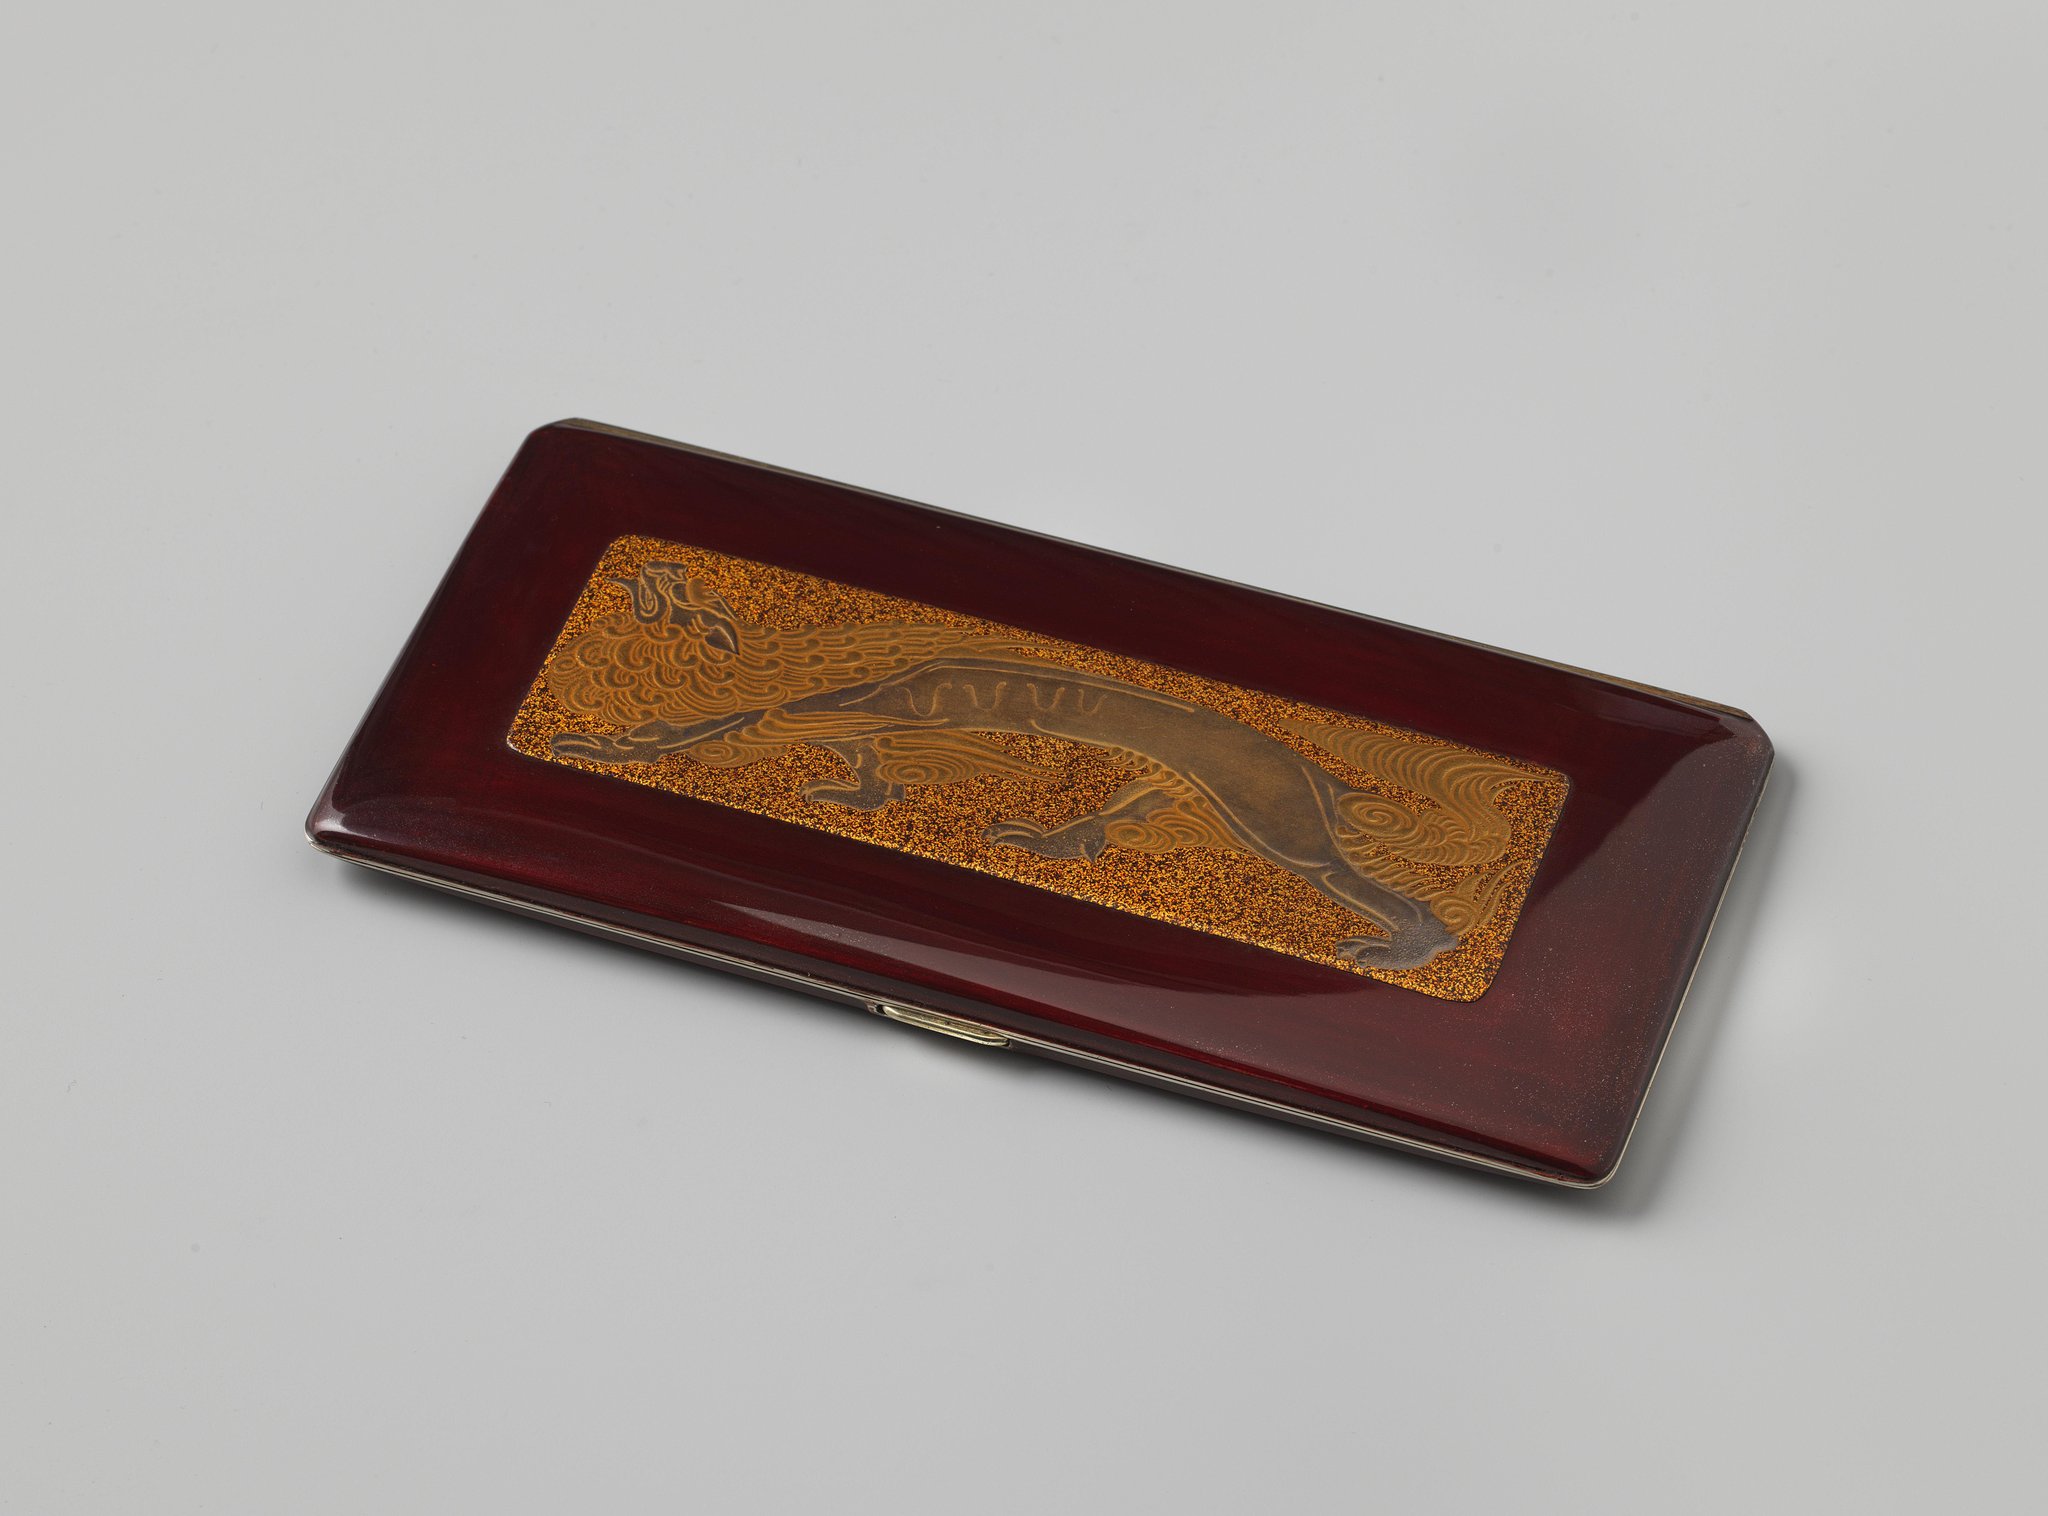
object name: sigarenkoker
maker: Anonymous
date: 1920-1945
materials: lacquer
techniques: lacquer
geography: japan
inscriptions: inscription: ‘Made in occupied Japan, … Pat. No. 150085’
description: Roodbruin gelakte of geëmailleerde metalen sigarettenkoker met een rechthoekig centraal paneel, waarop een sluipende shishi in goudlak staat afgebeeld tegen een achtergrond van nashiji.